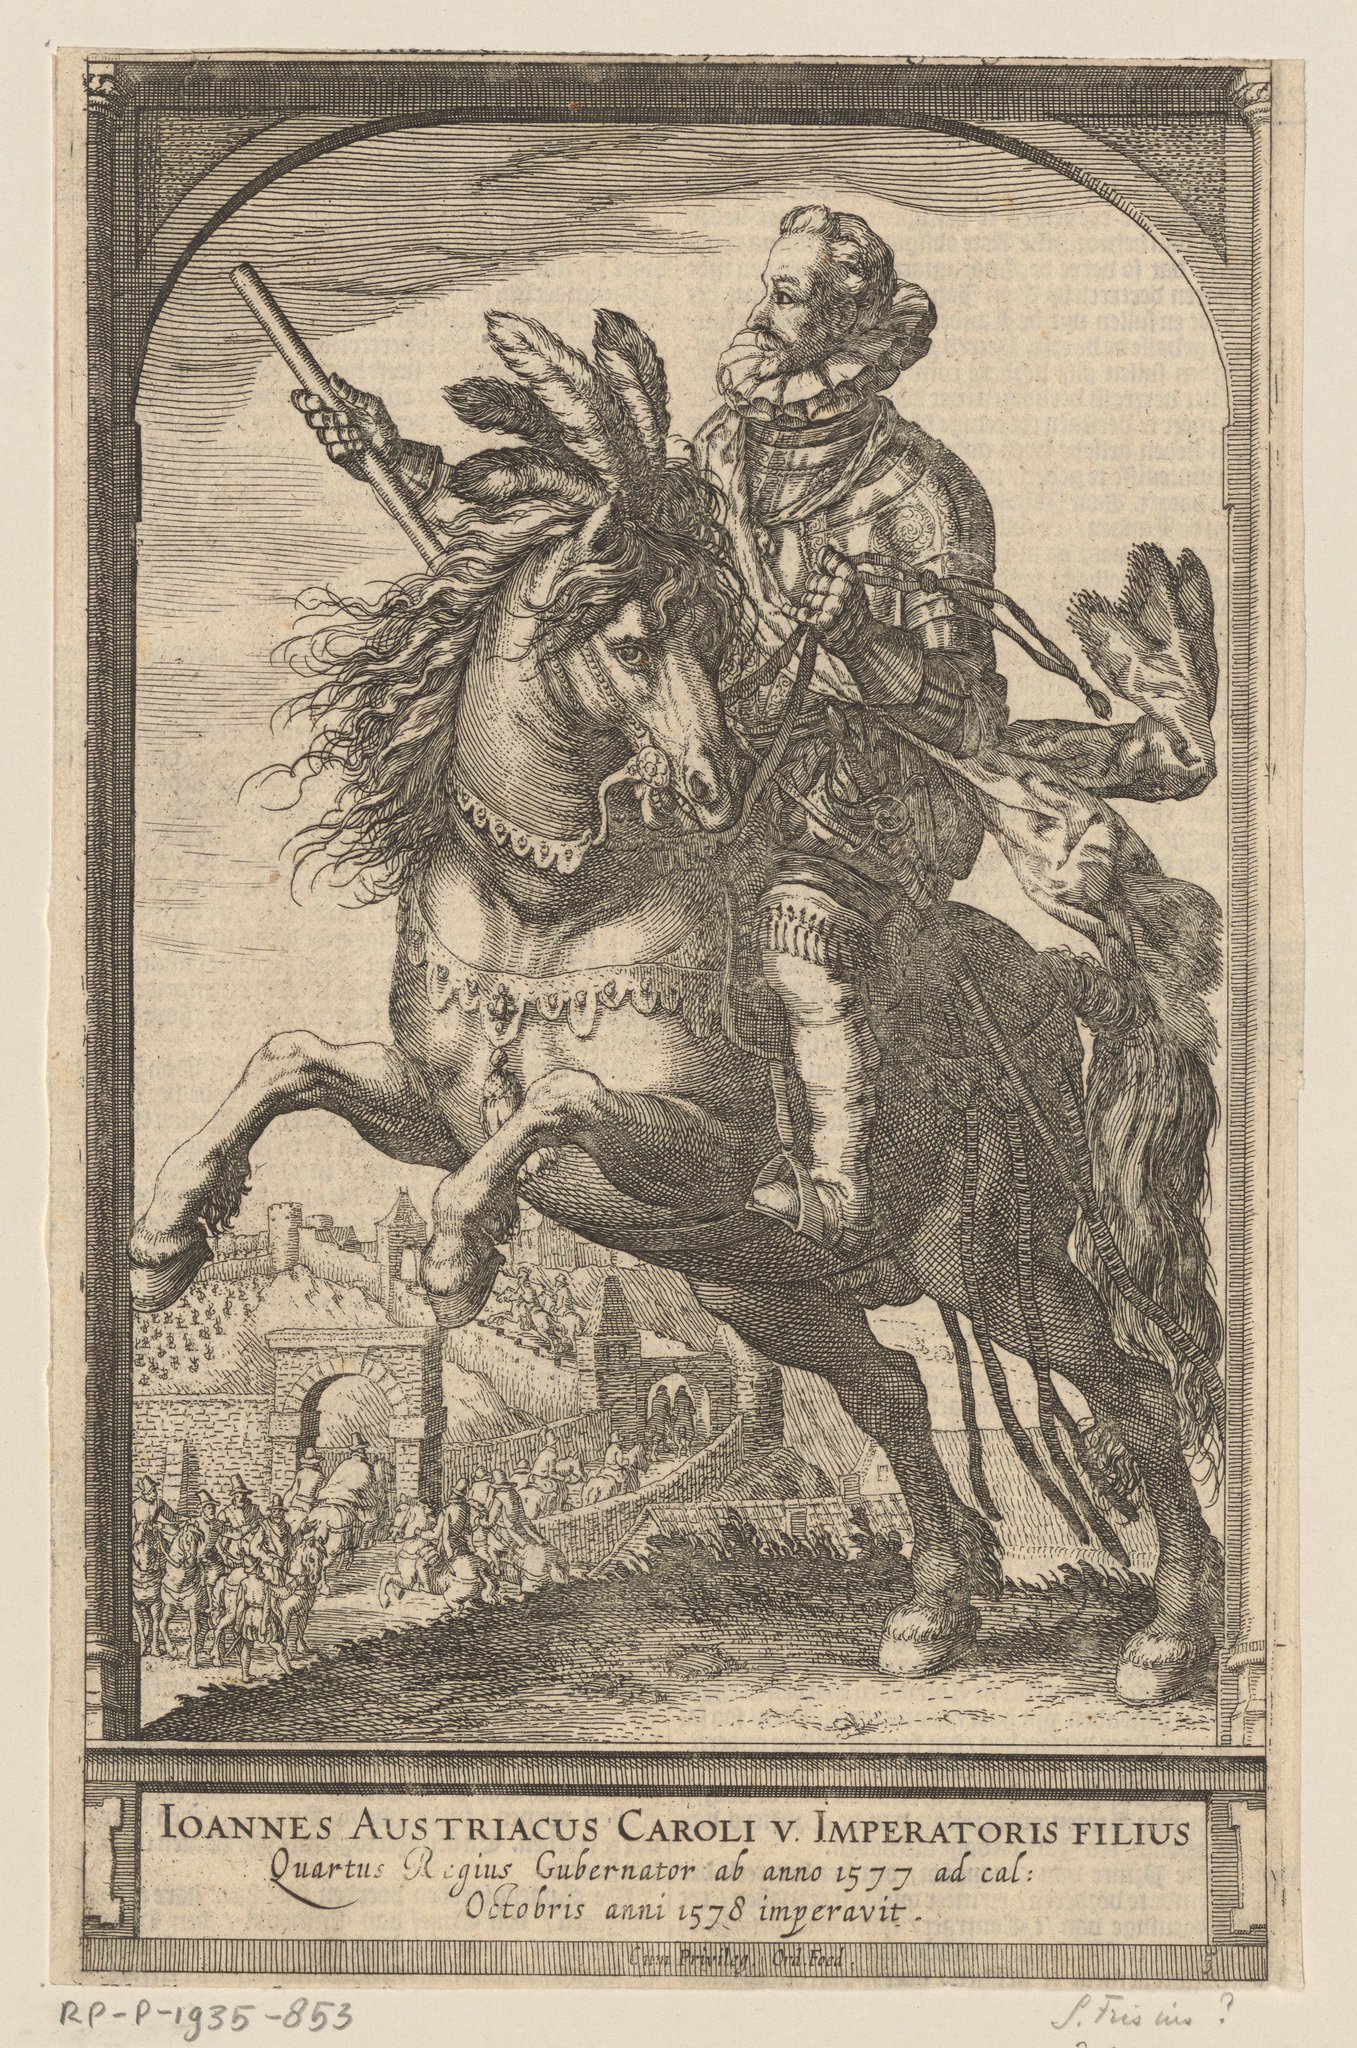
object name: print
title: Portret van Don Juan van Oostenrijk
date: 1632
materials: paper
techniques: etching, letterpress printing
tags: don juan van oostenrijk, castle, historical persons, knighthood order of the golden fleece, equestrian statue, ruler, sovereign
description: Prent met andere tekst op verso gebruikt in: Meteren, Emanuel van. Historien der Nederlanden, en haar naburen oorlogen tot het jaar 1612. Rotterdam: Jan Jacobsz. Schipper, 1632. Prent ook gebruikt in latere edities.